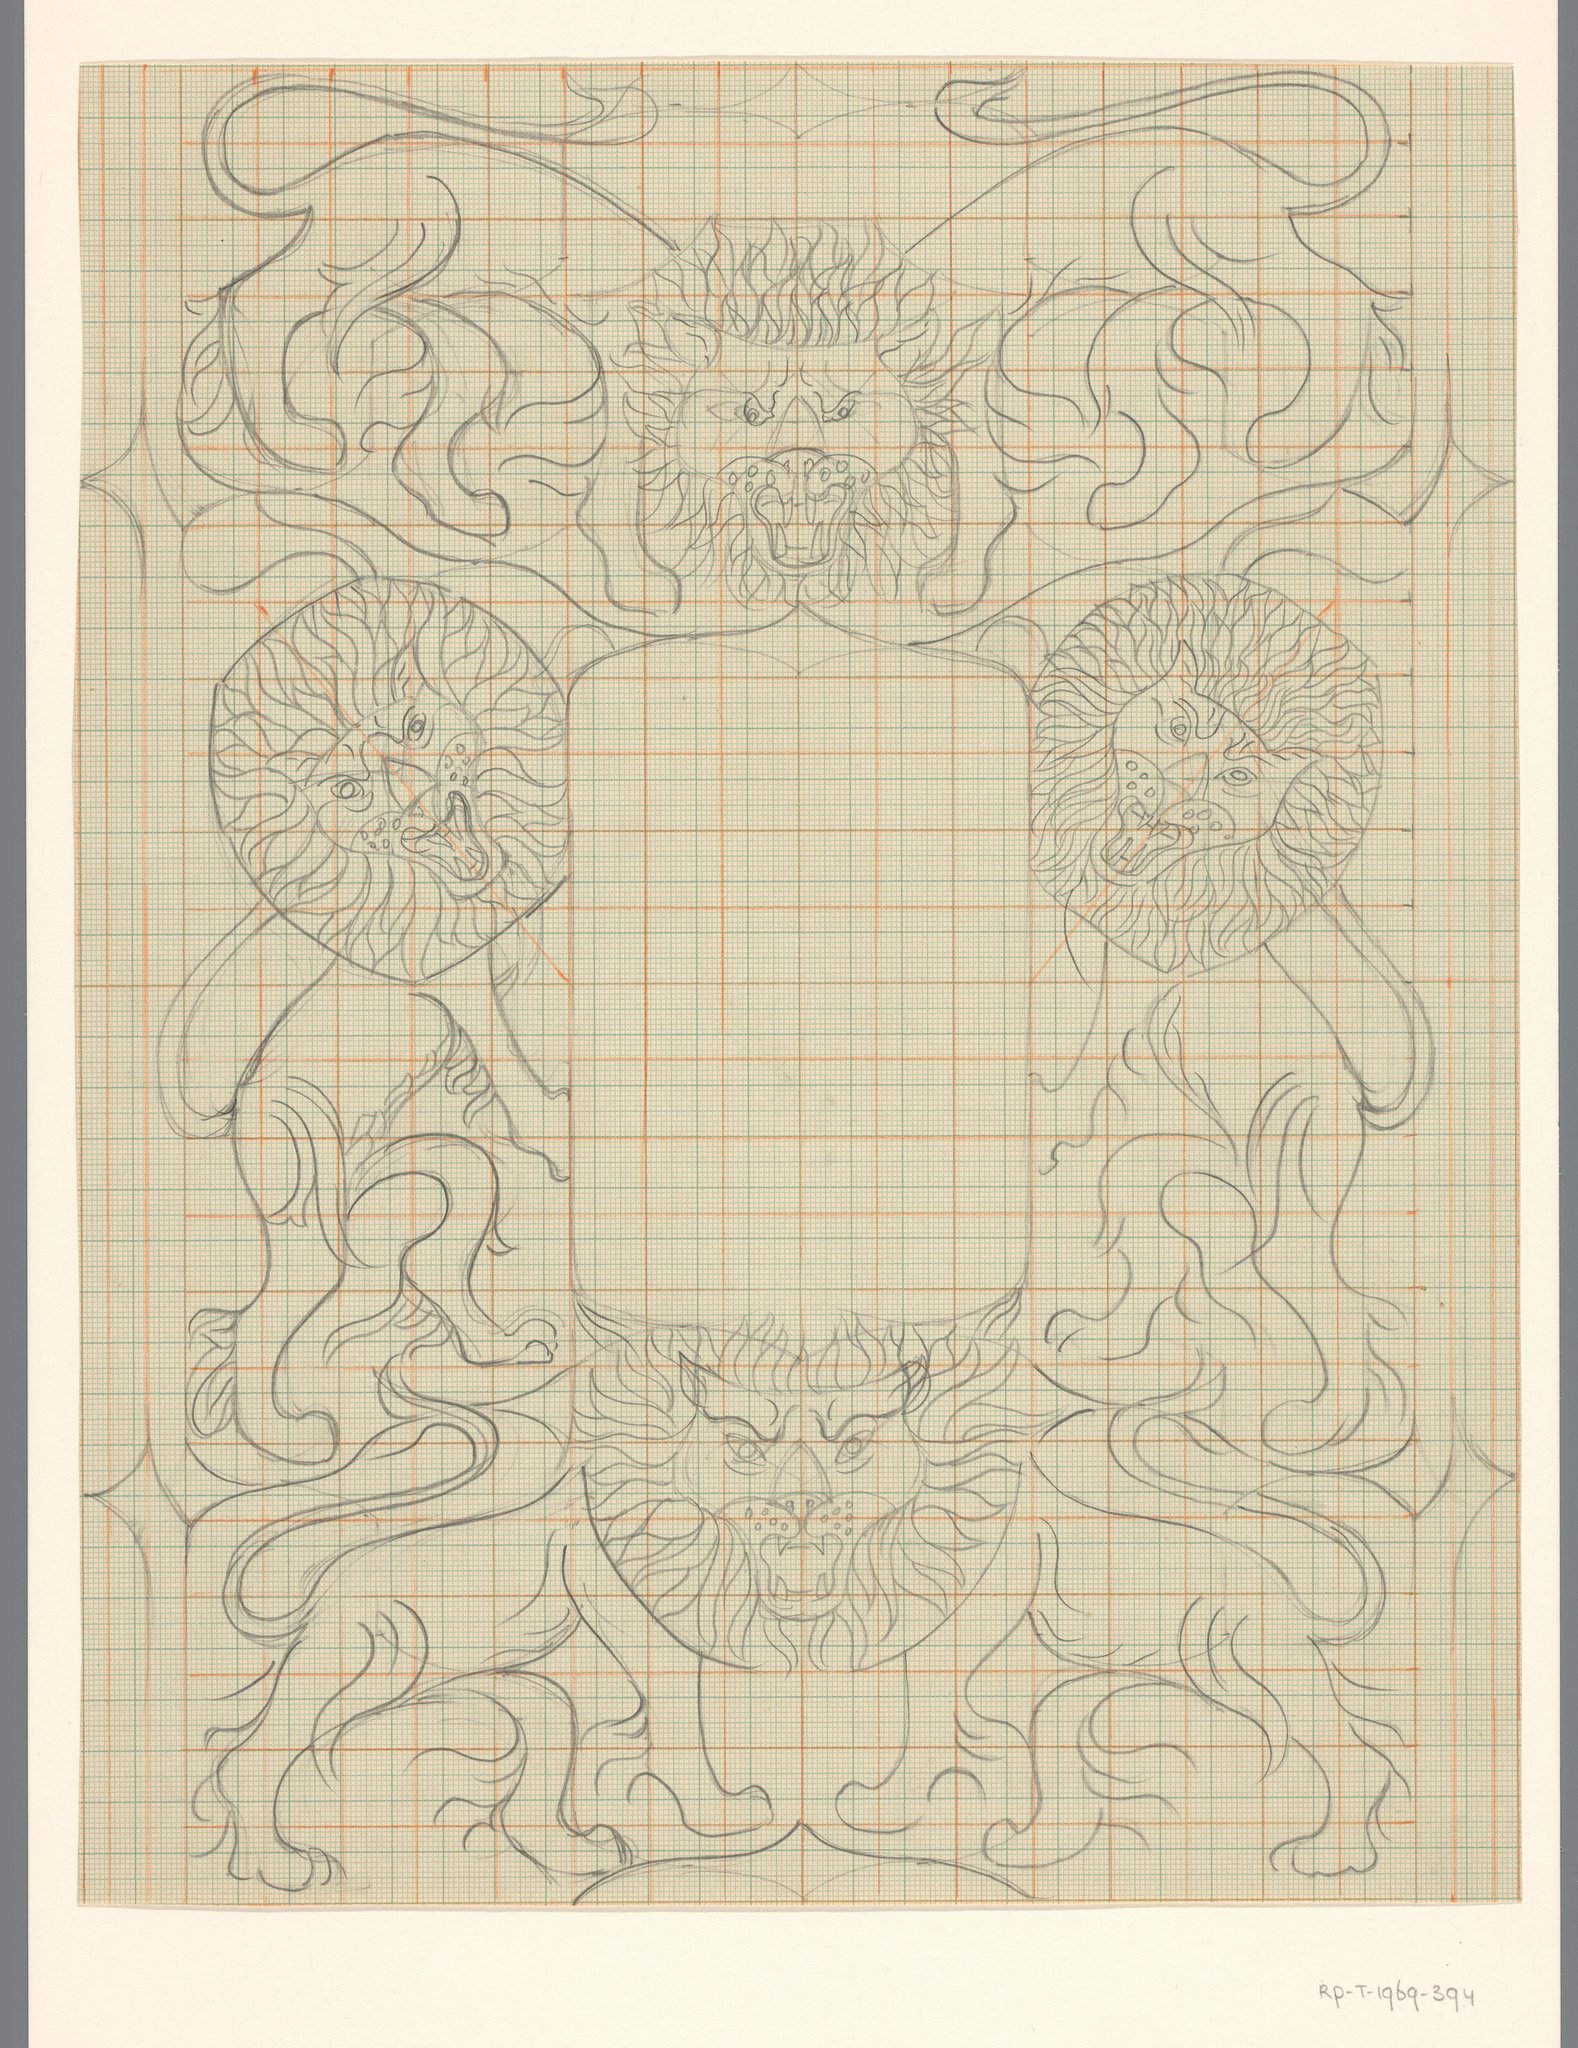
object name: drawing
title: Ornamentaal ontwerp met leeuwen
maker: carel adolph lion cachet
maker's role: draughtsman, print maker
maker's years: 1864-1945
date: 1874-1945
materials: pencil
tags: ornament derived from animal forms, beasts of prey, predatory animals: lion